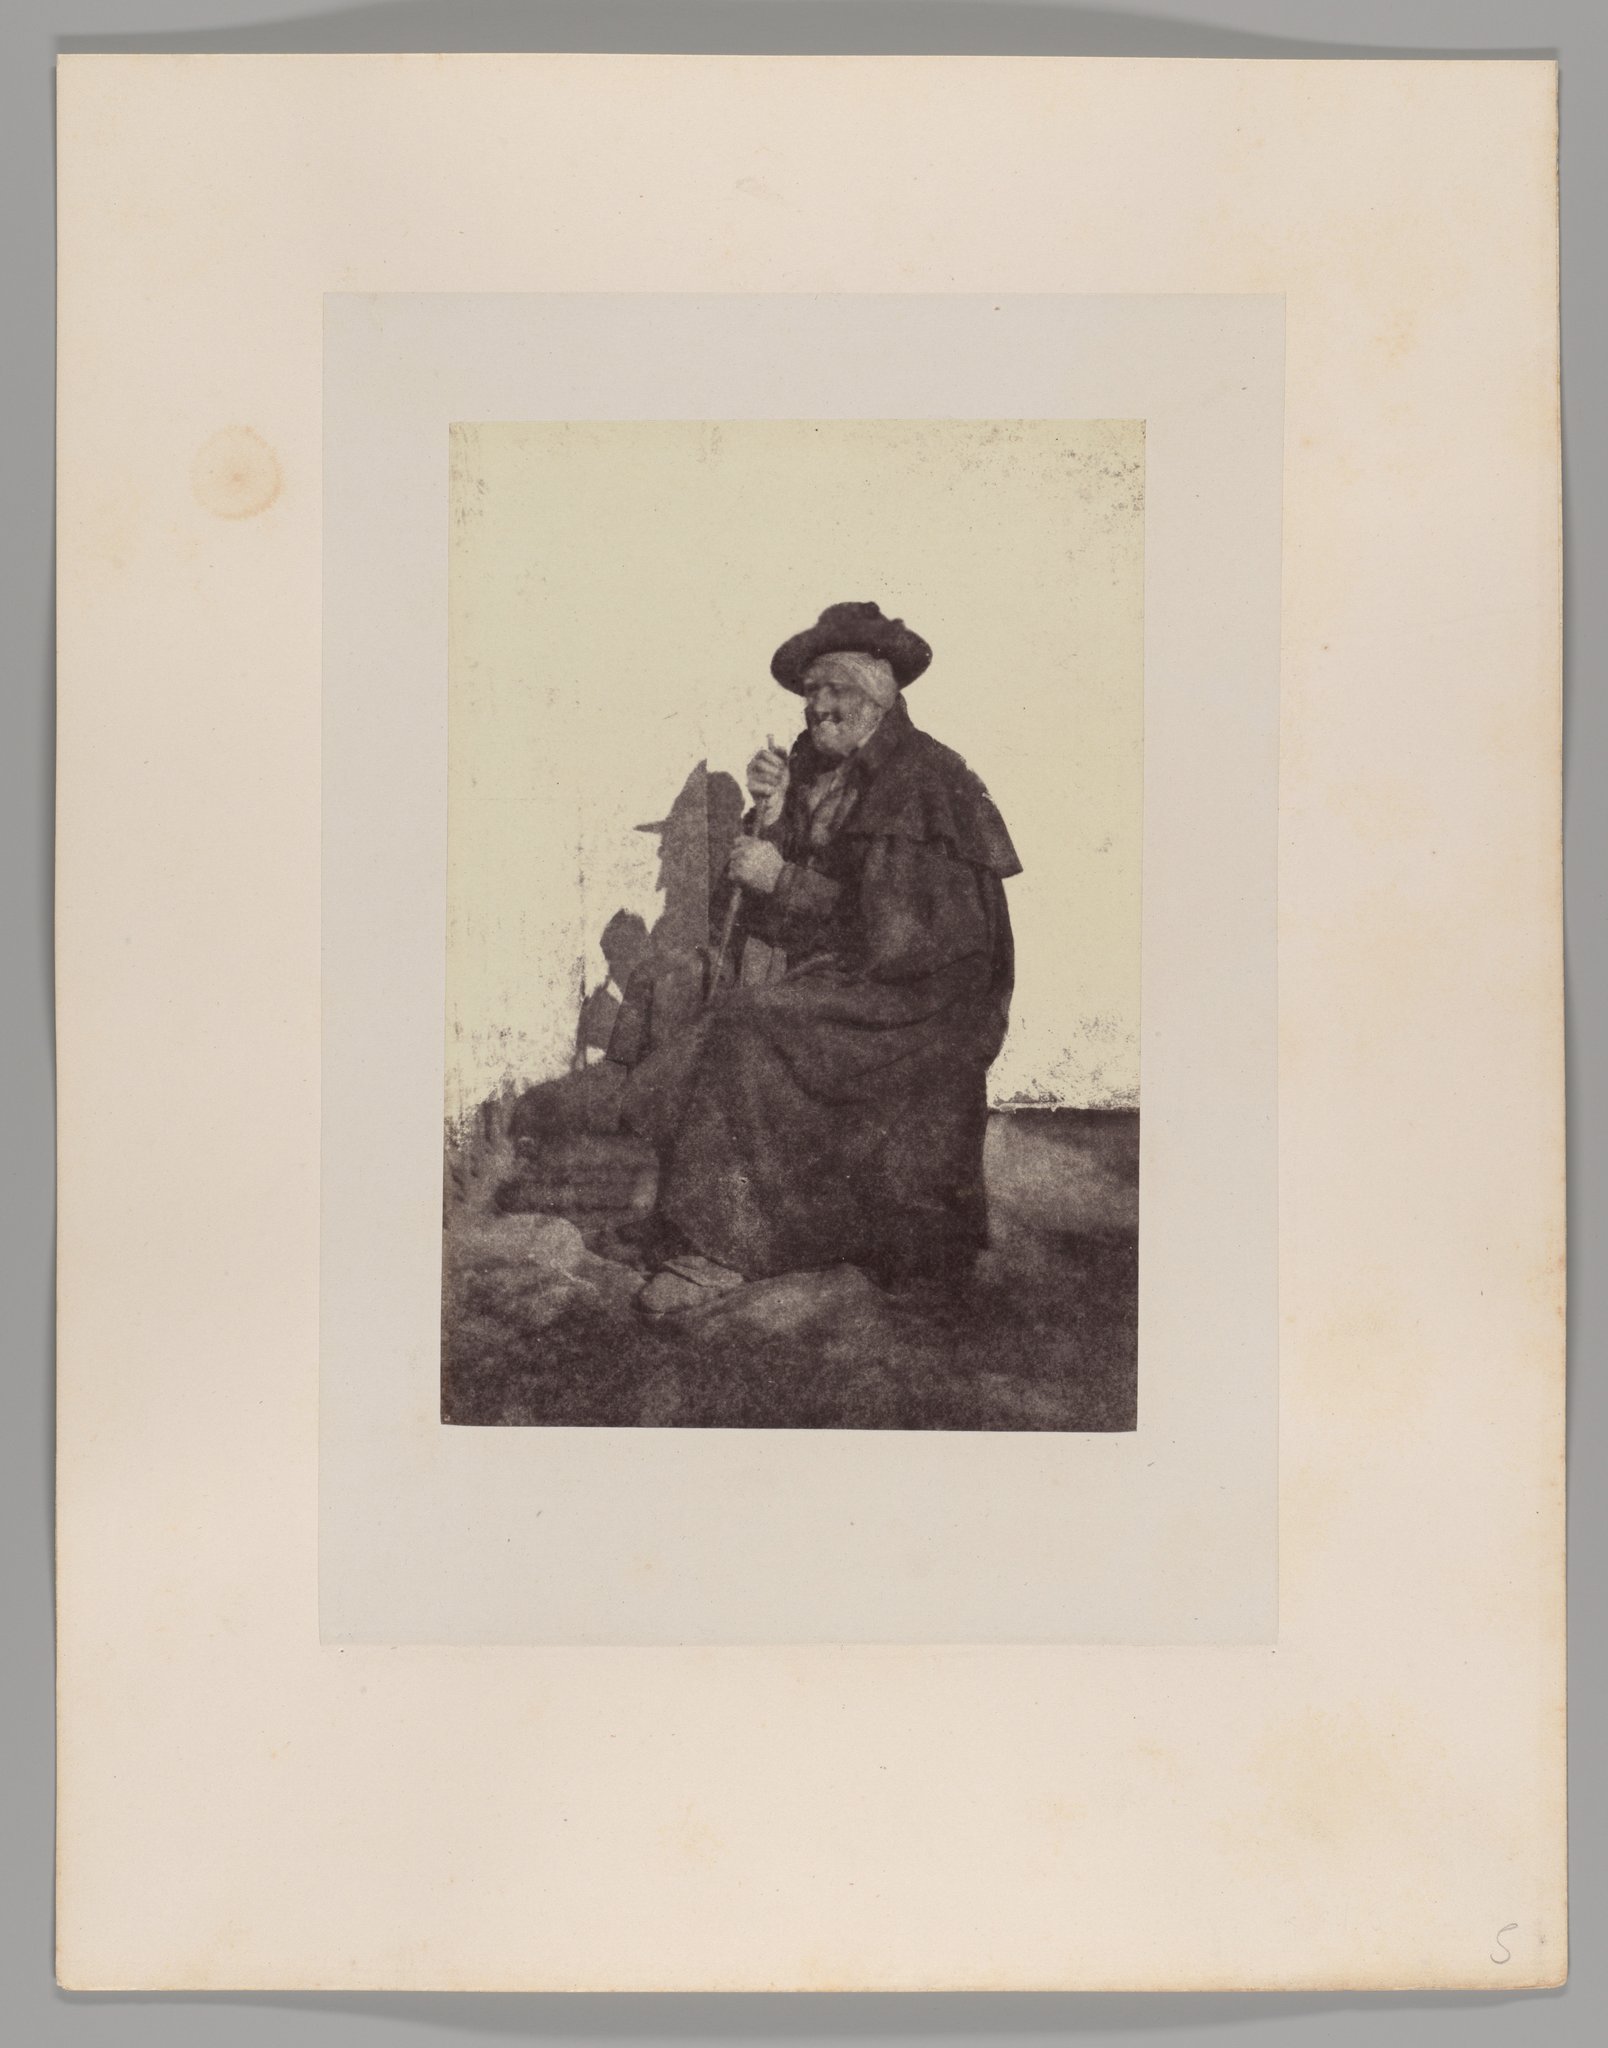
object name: photograph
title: [Elderly Man, Spain]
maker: alphonse delaunay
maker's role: artist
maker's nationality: french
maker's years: 1827-1906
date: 1851-1854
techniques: albumen silver print, paper negative